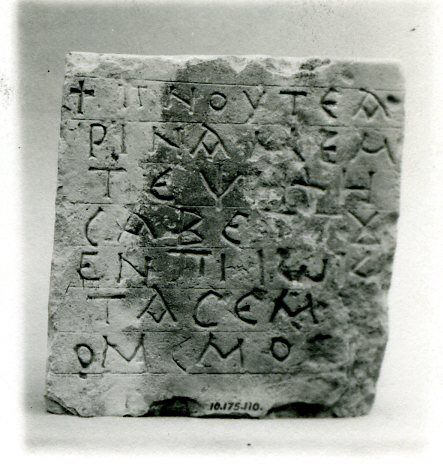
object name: stele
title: Inscribed Stele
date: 501-700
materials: limestone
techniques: incising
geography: egypt